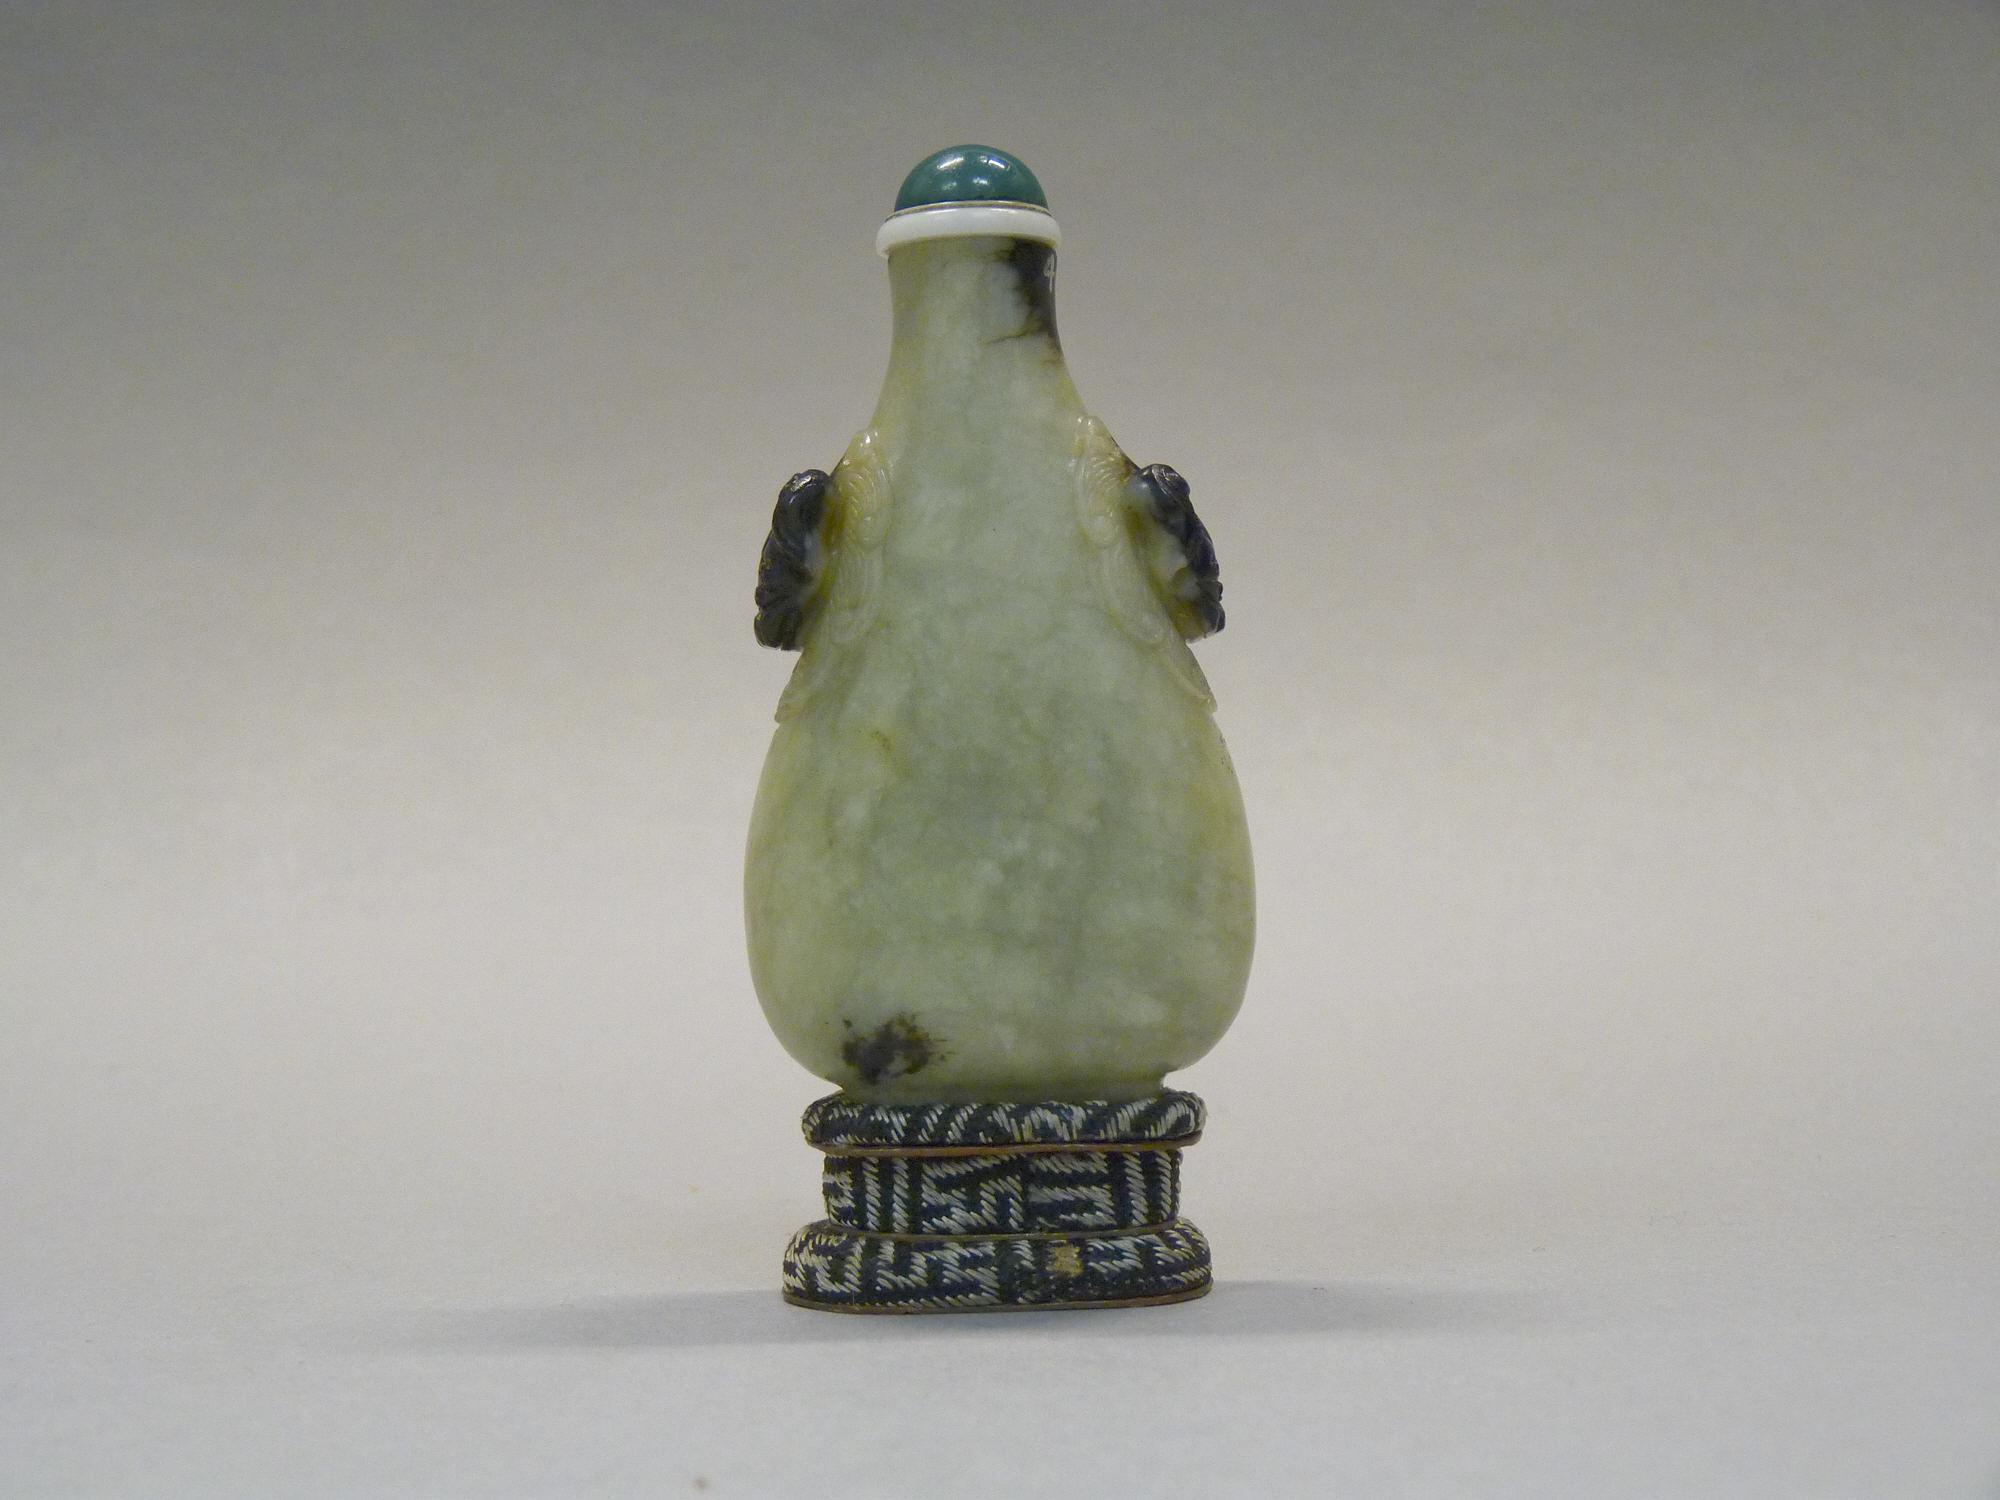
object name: snuff bottle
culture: chinese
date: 1736-1795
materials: jade, silk